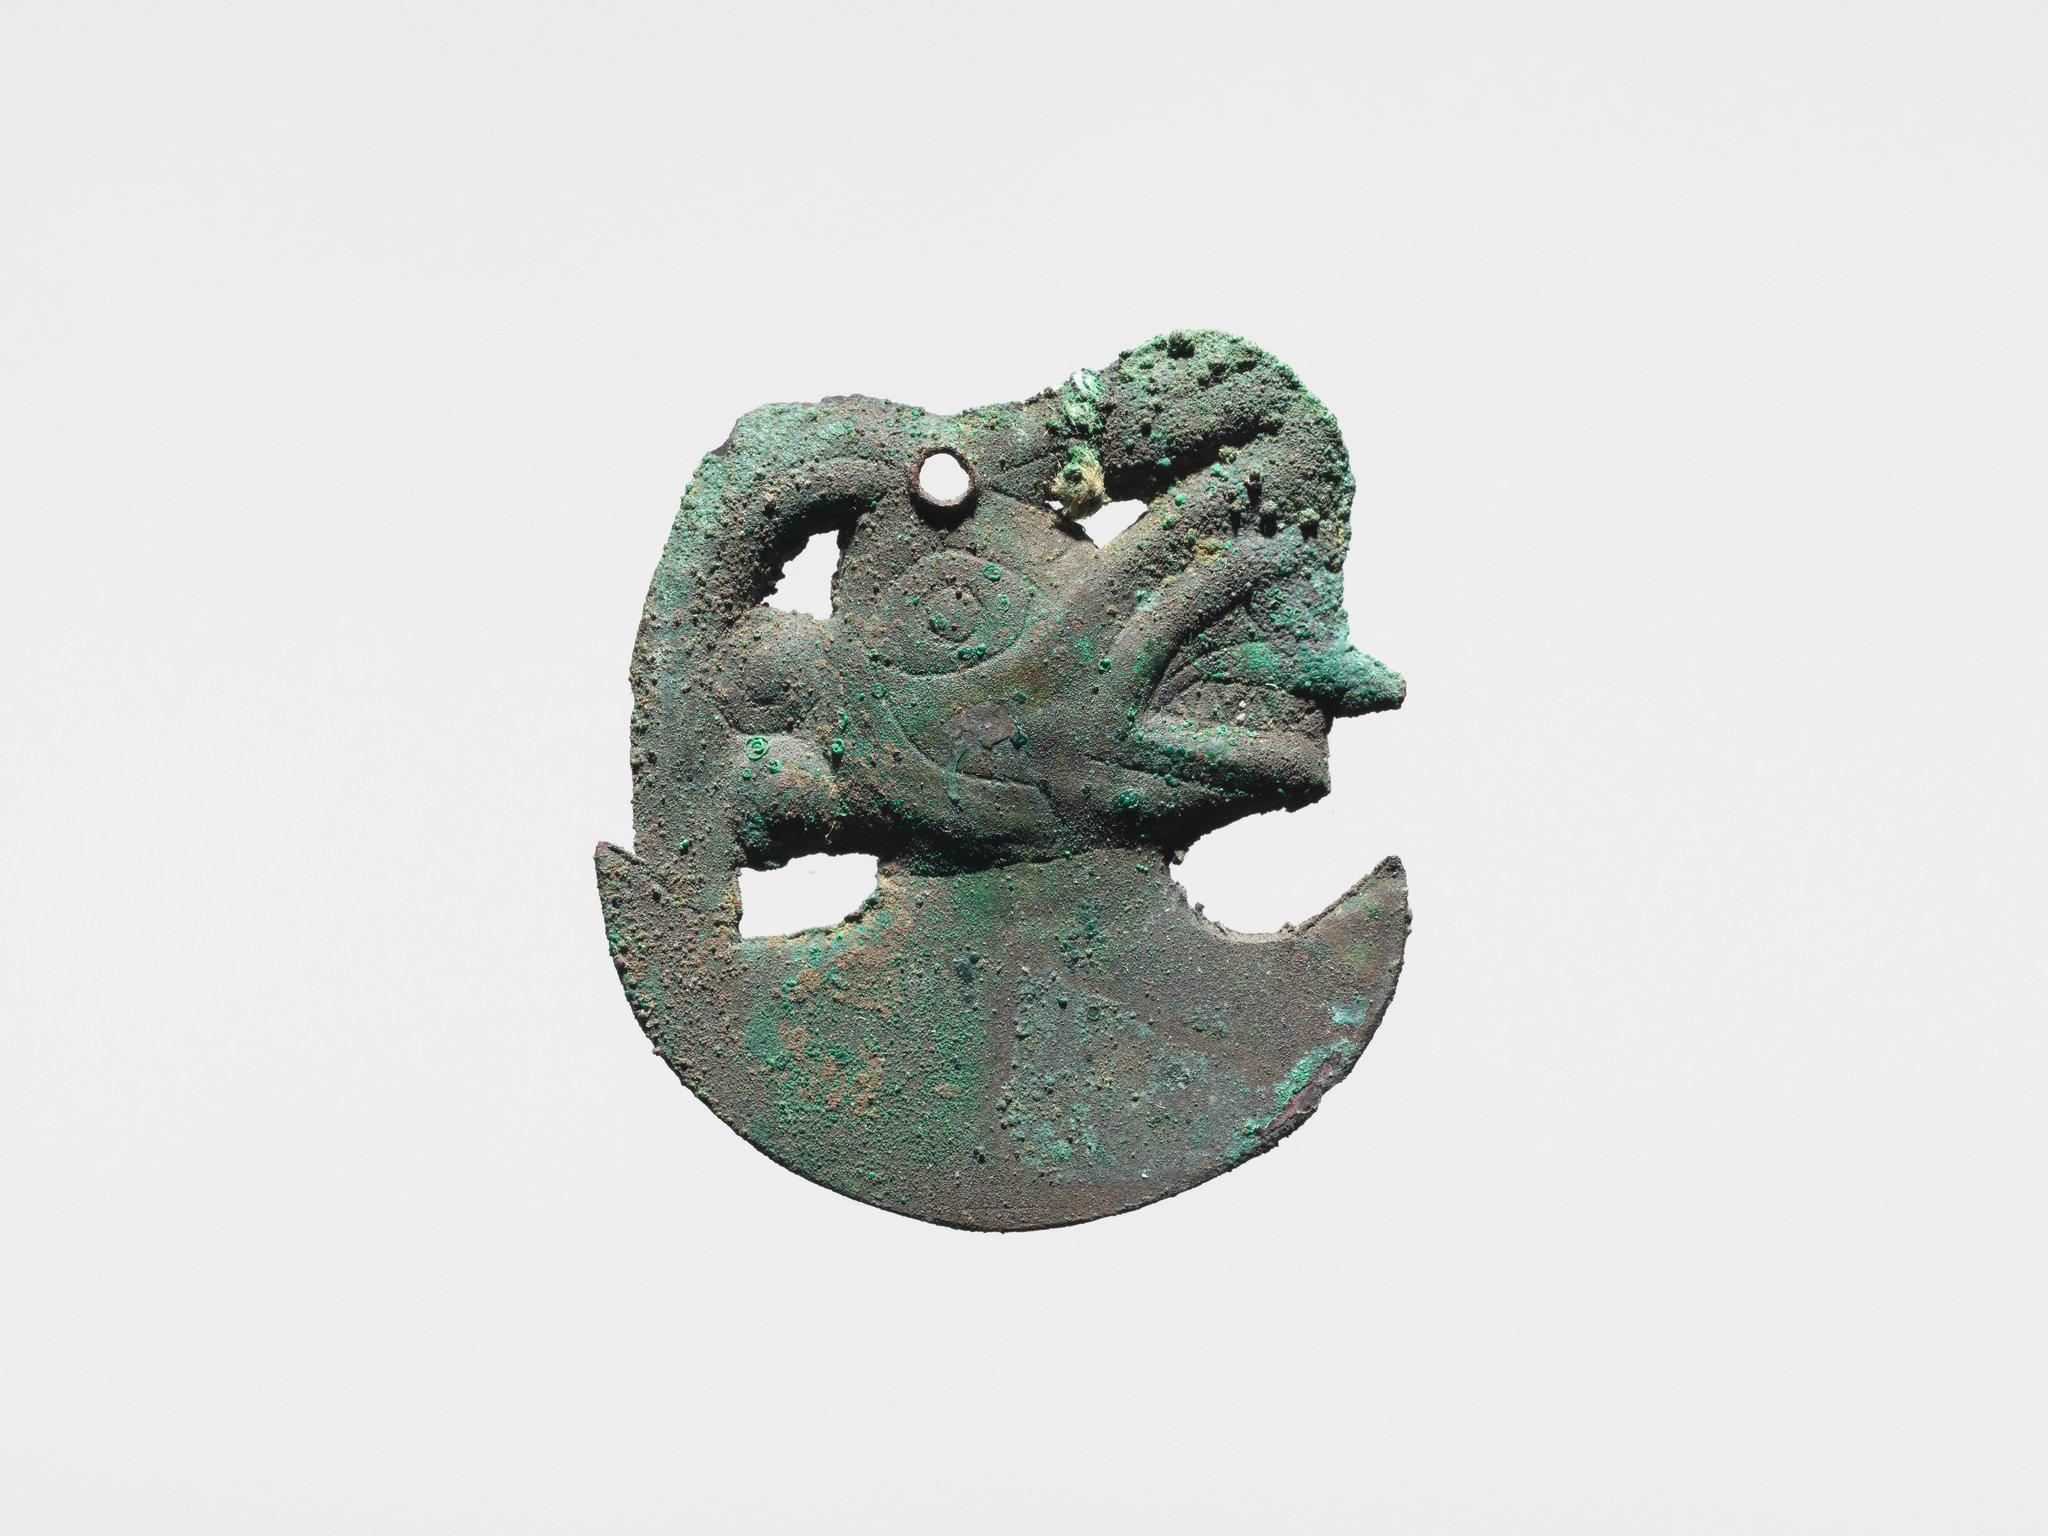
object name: ornament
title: Crescent Ornaments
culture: moche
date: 501-700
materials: gilt copper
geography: peru